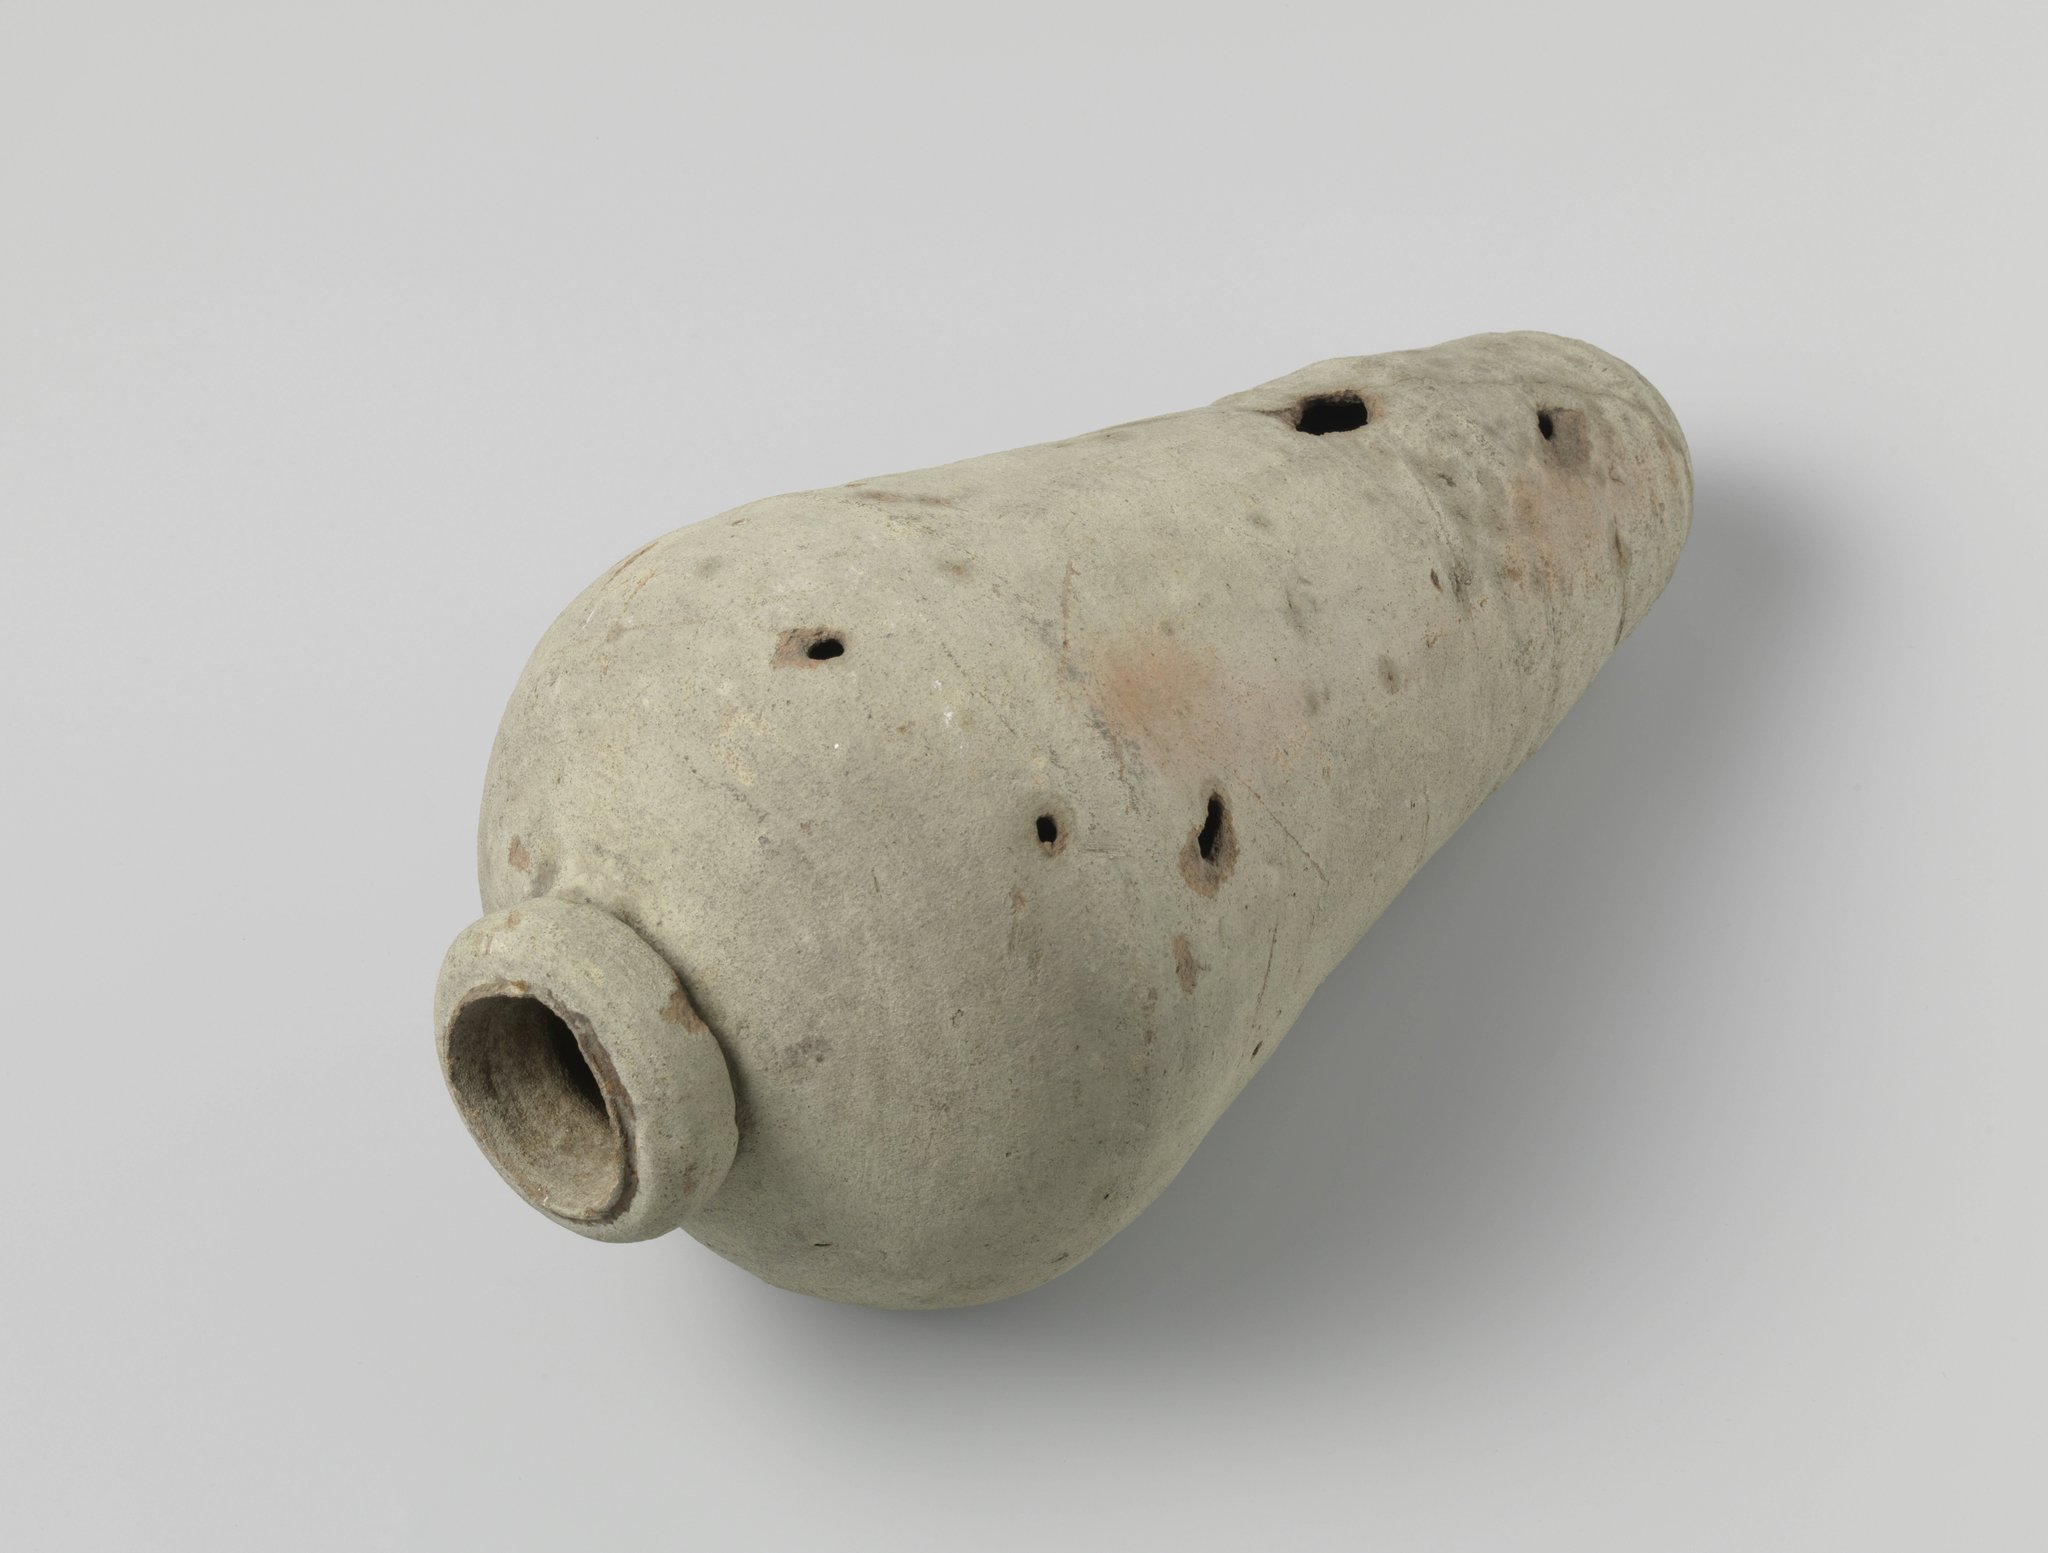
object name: pot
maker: Anonymous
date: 1600-1800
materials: earthenware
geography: italy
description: Langwerpige, spits naar onderen toelopende pot van aardewerk. Bij de pot horen twee potten met invnr. BK-KOG-485 en BK-KOG-486. Alle drie de potten zijn bodemvondsten.